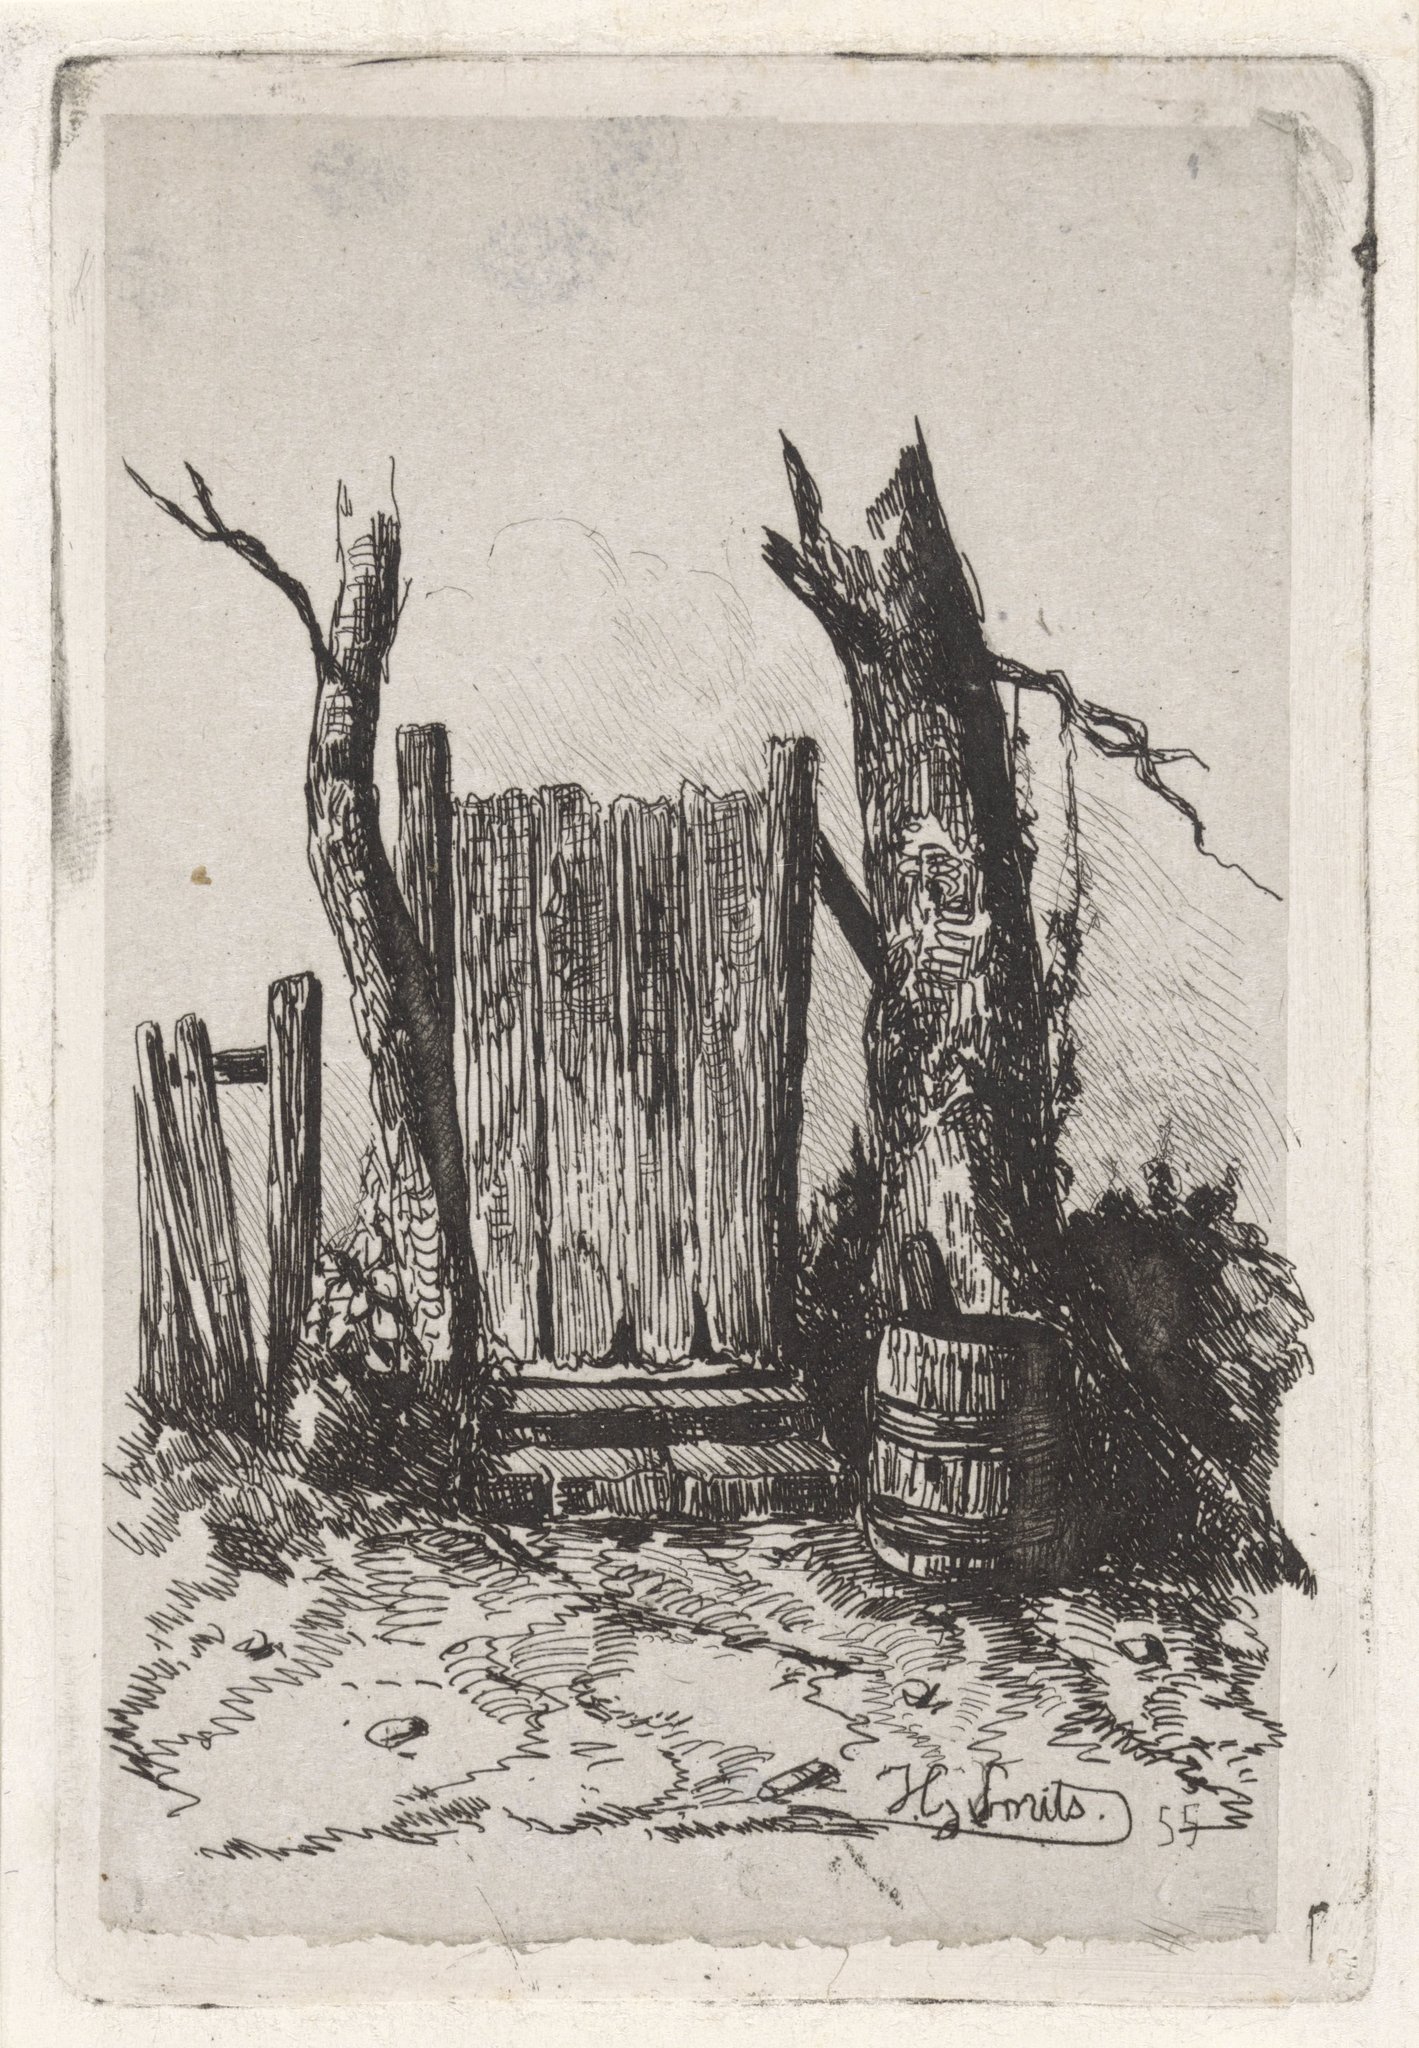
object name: print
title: Houten poortje met regenton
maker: jan gerard smits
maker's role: draughtsman, print maker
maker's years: 1823-1910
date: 1855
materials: paper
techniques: etching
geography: the hague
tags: gate, entrance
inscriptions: collector's mark: Lugt 2228